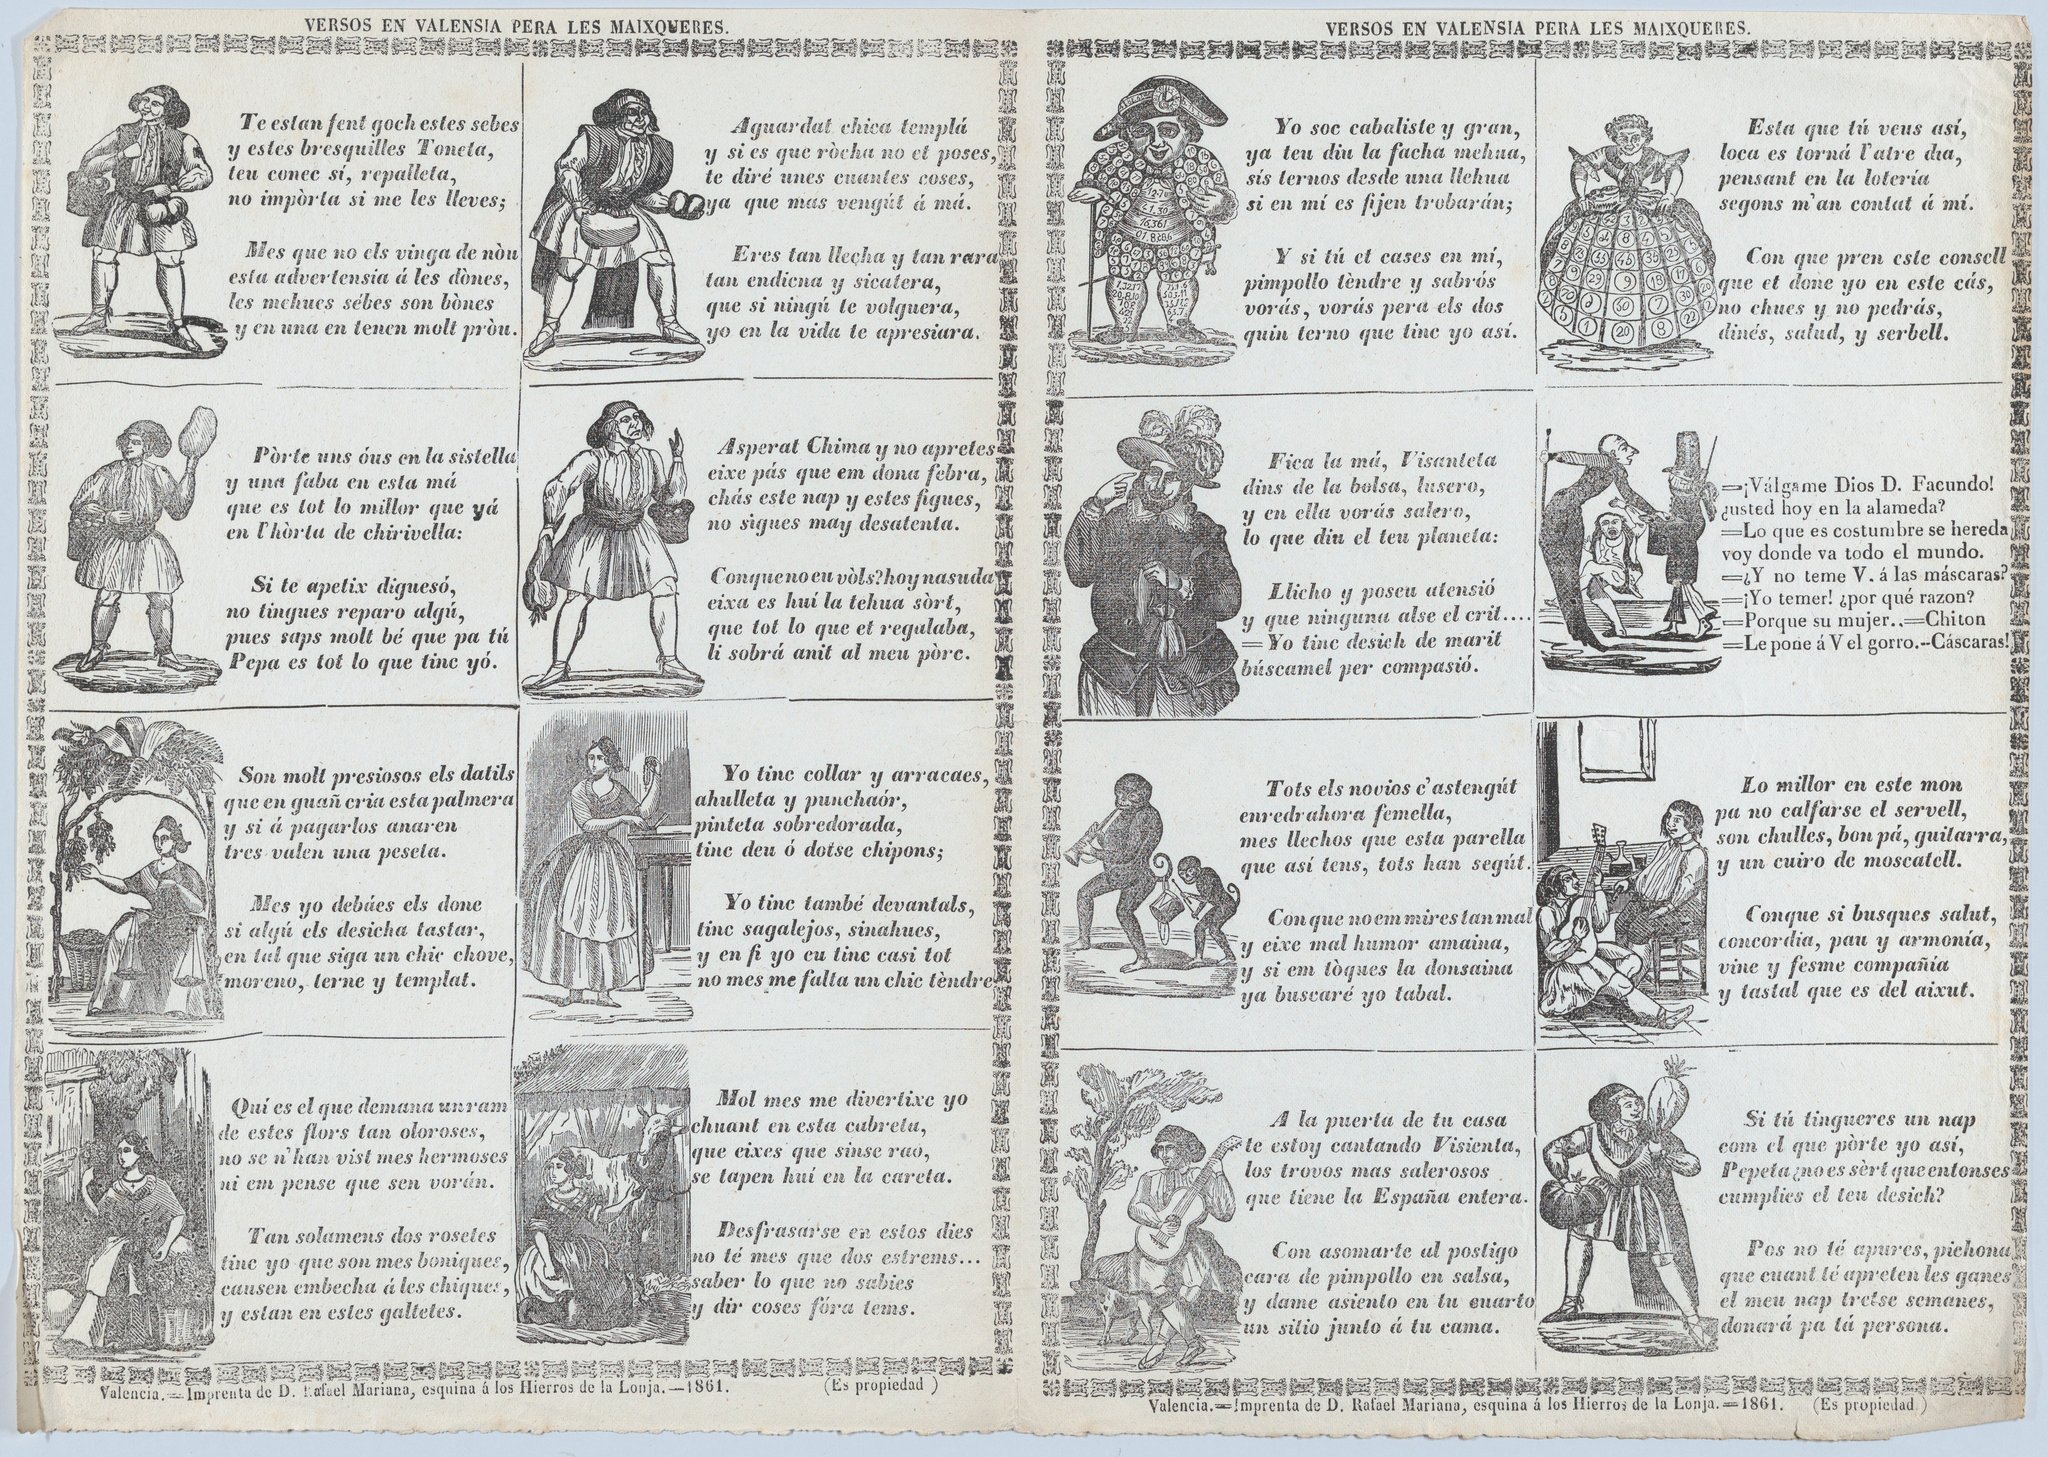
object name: print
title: Two sheets (printed as one) with verses in Valencian for masquerades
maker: rafael mariana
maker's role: publisher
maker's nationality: spanish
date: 1861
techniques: letterpress, engraving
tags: men,women,monkeys,musicians